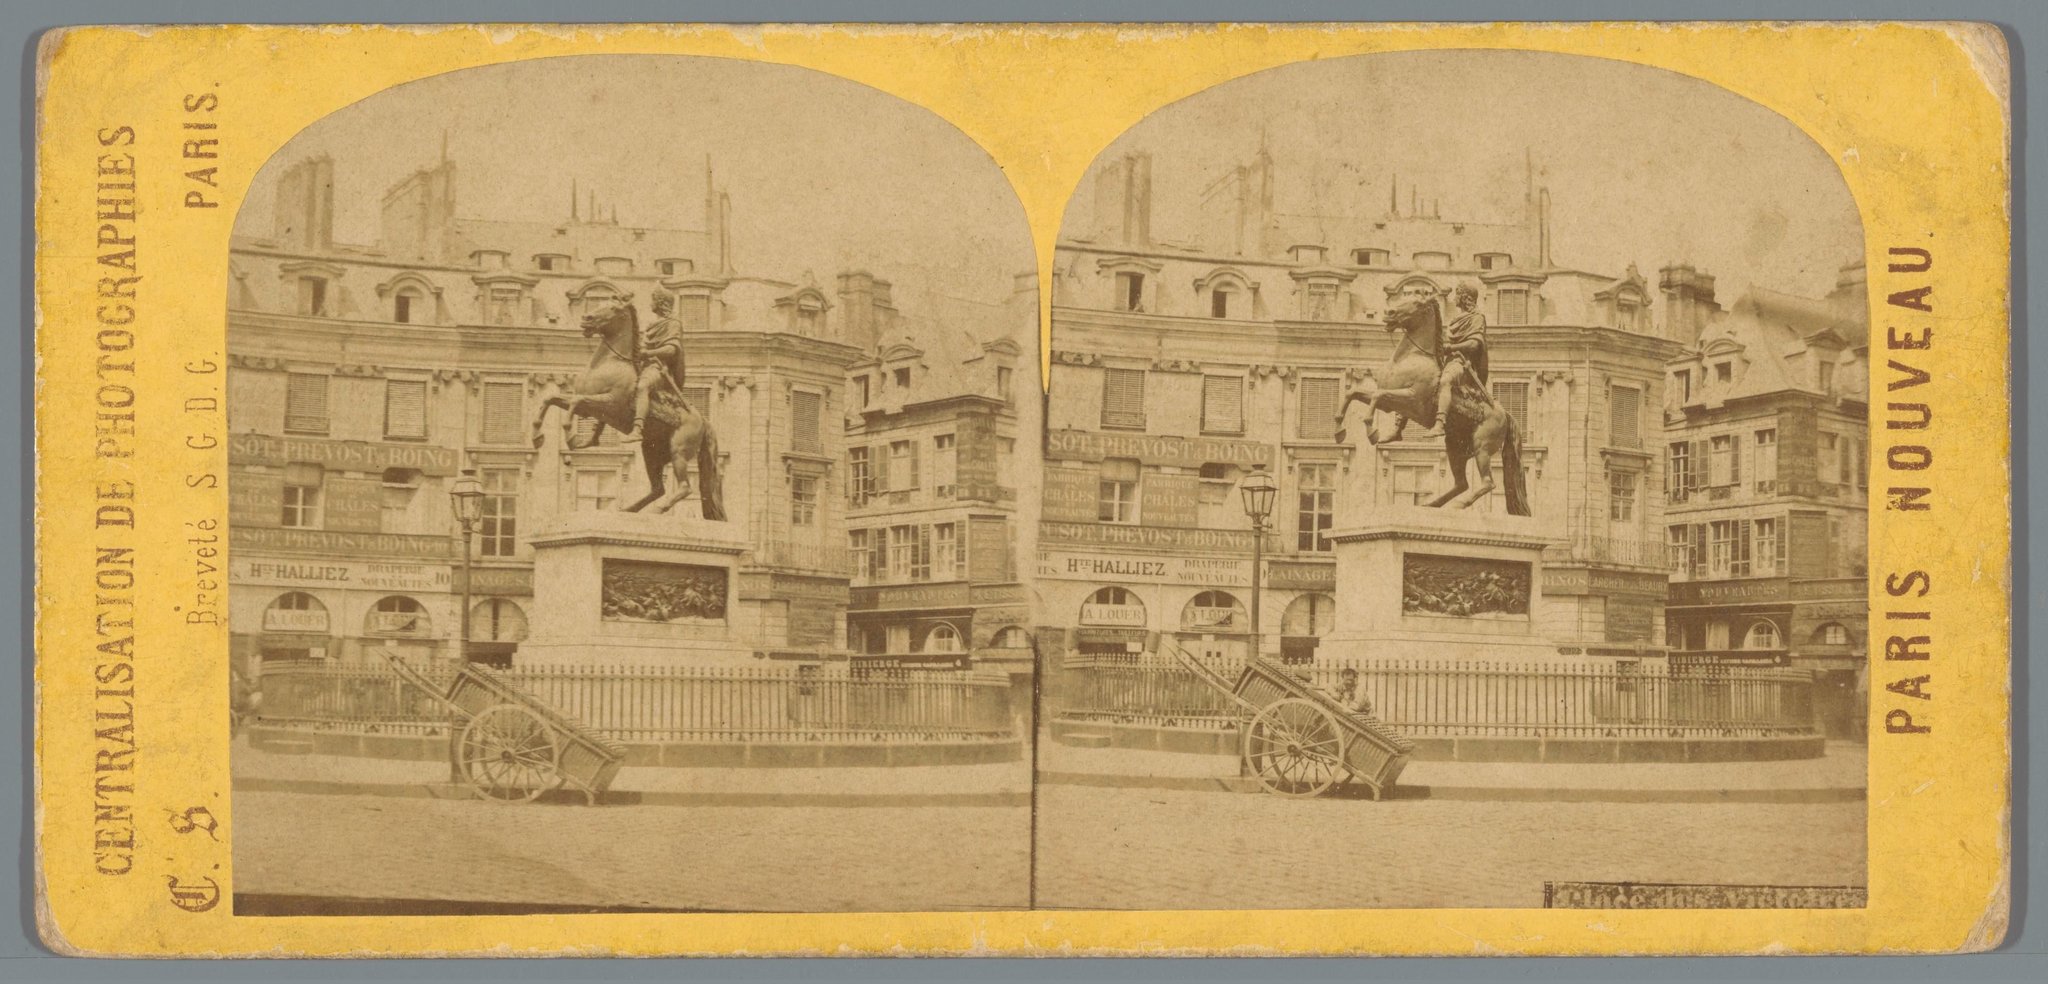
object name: stereograph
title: Place des Victoires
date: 1850-1880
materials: cardboard, photographic support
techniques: albumen print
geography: paris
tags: lodewijk xiv (koning van frankrijk), square, place, circus, etc., equestrian statue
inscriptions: inscription: ‘Breveté S.G.D.G.’, inscription: ‘Place des Victoires’